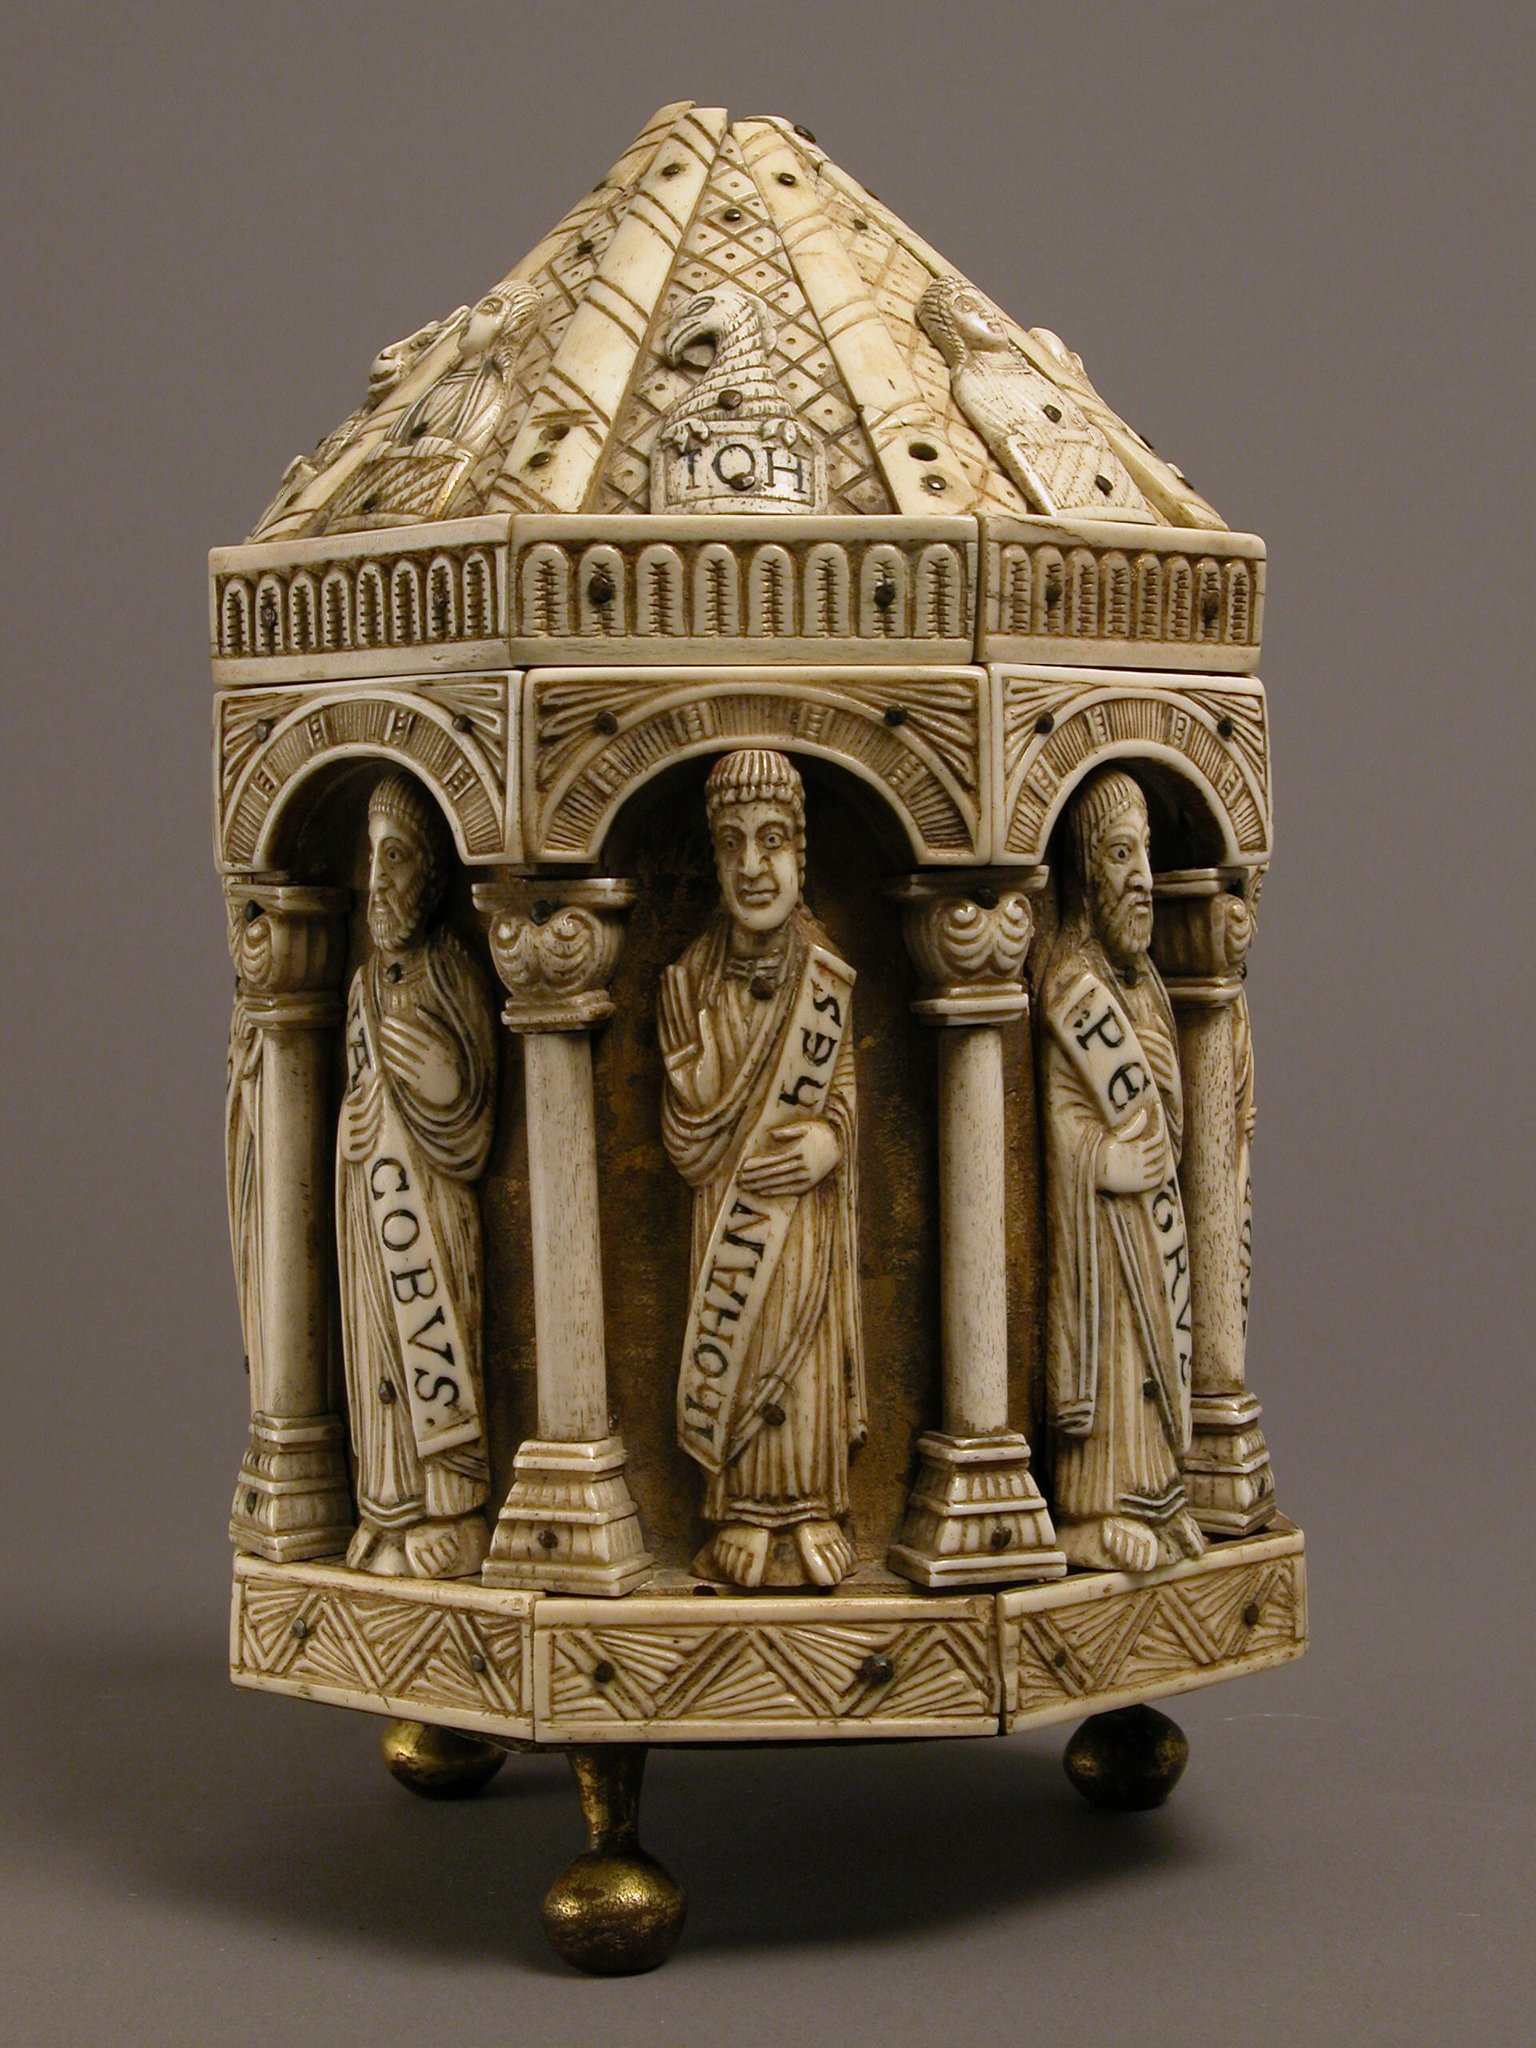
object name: reliquary box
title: Tower Reliquary with Eight Apostles and the Symbols of the Four Evangelists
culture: german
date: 1200-1250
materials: bone, copper alloy, gilt, wood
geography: germany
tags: animals,birds,apostles